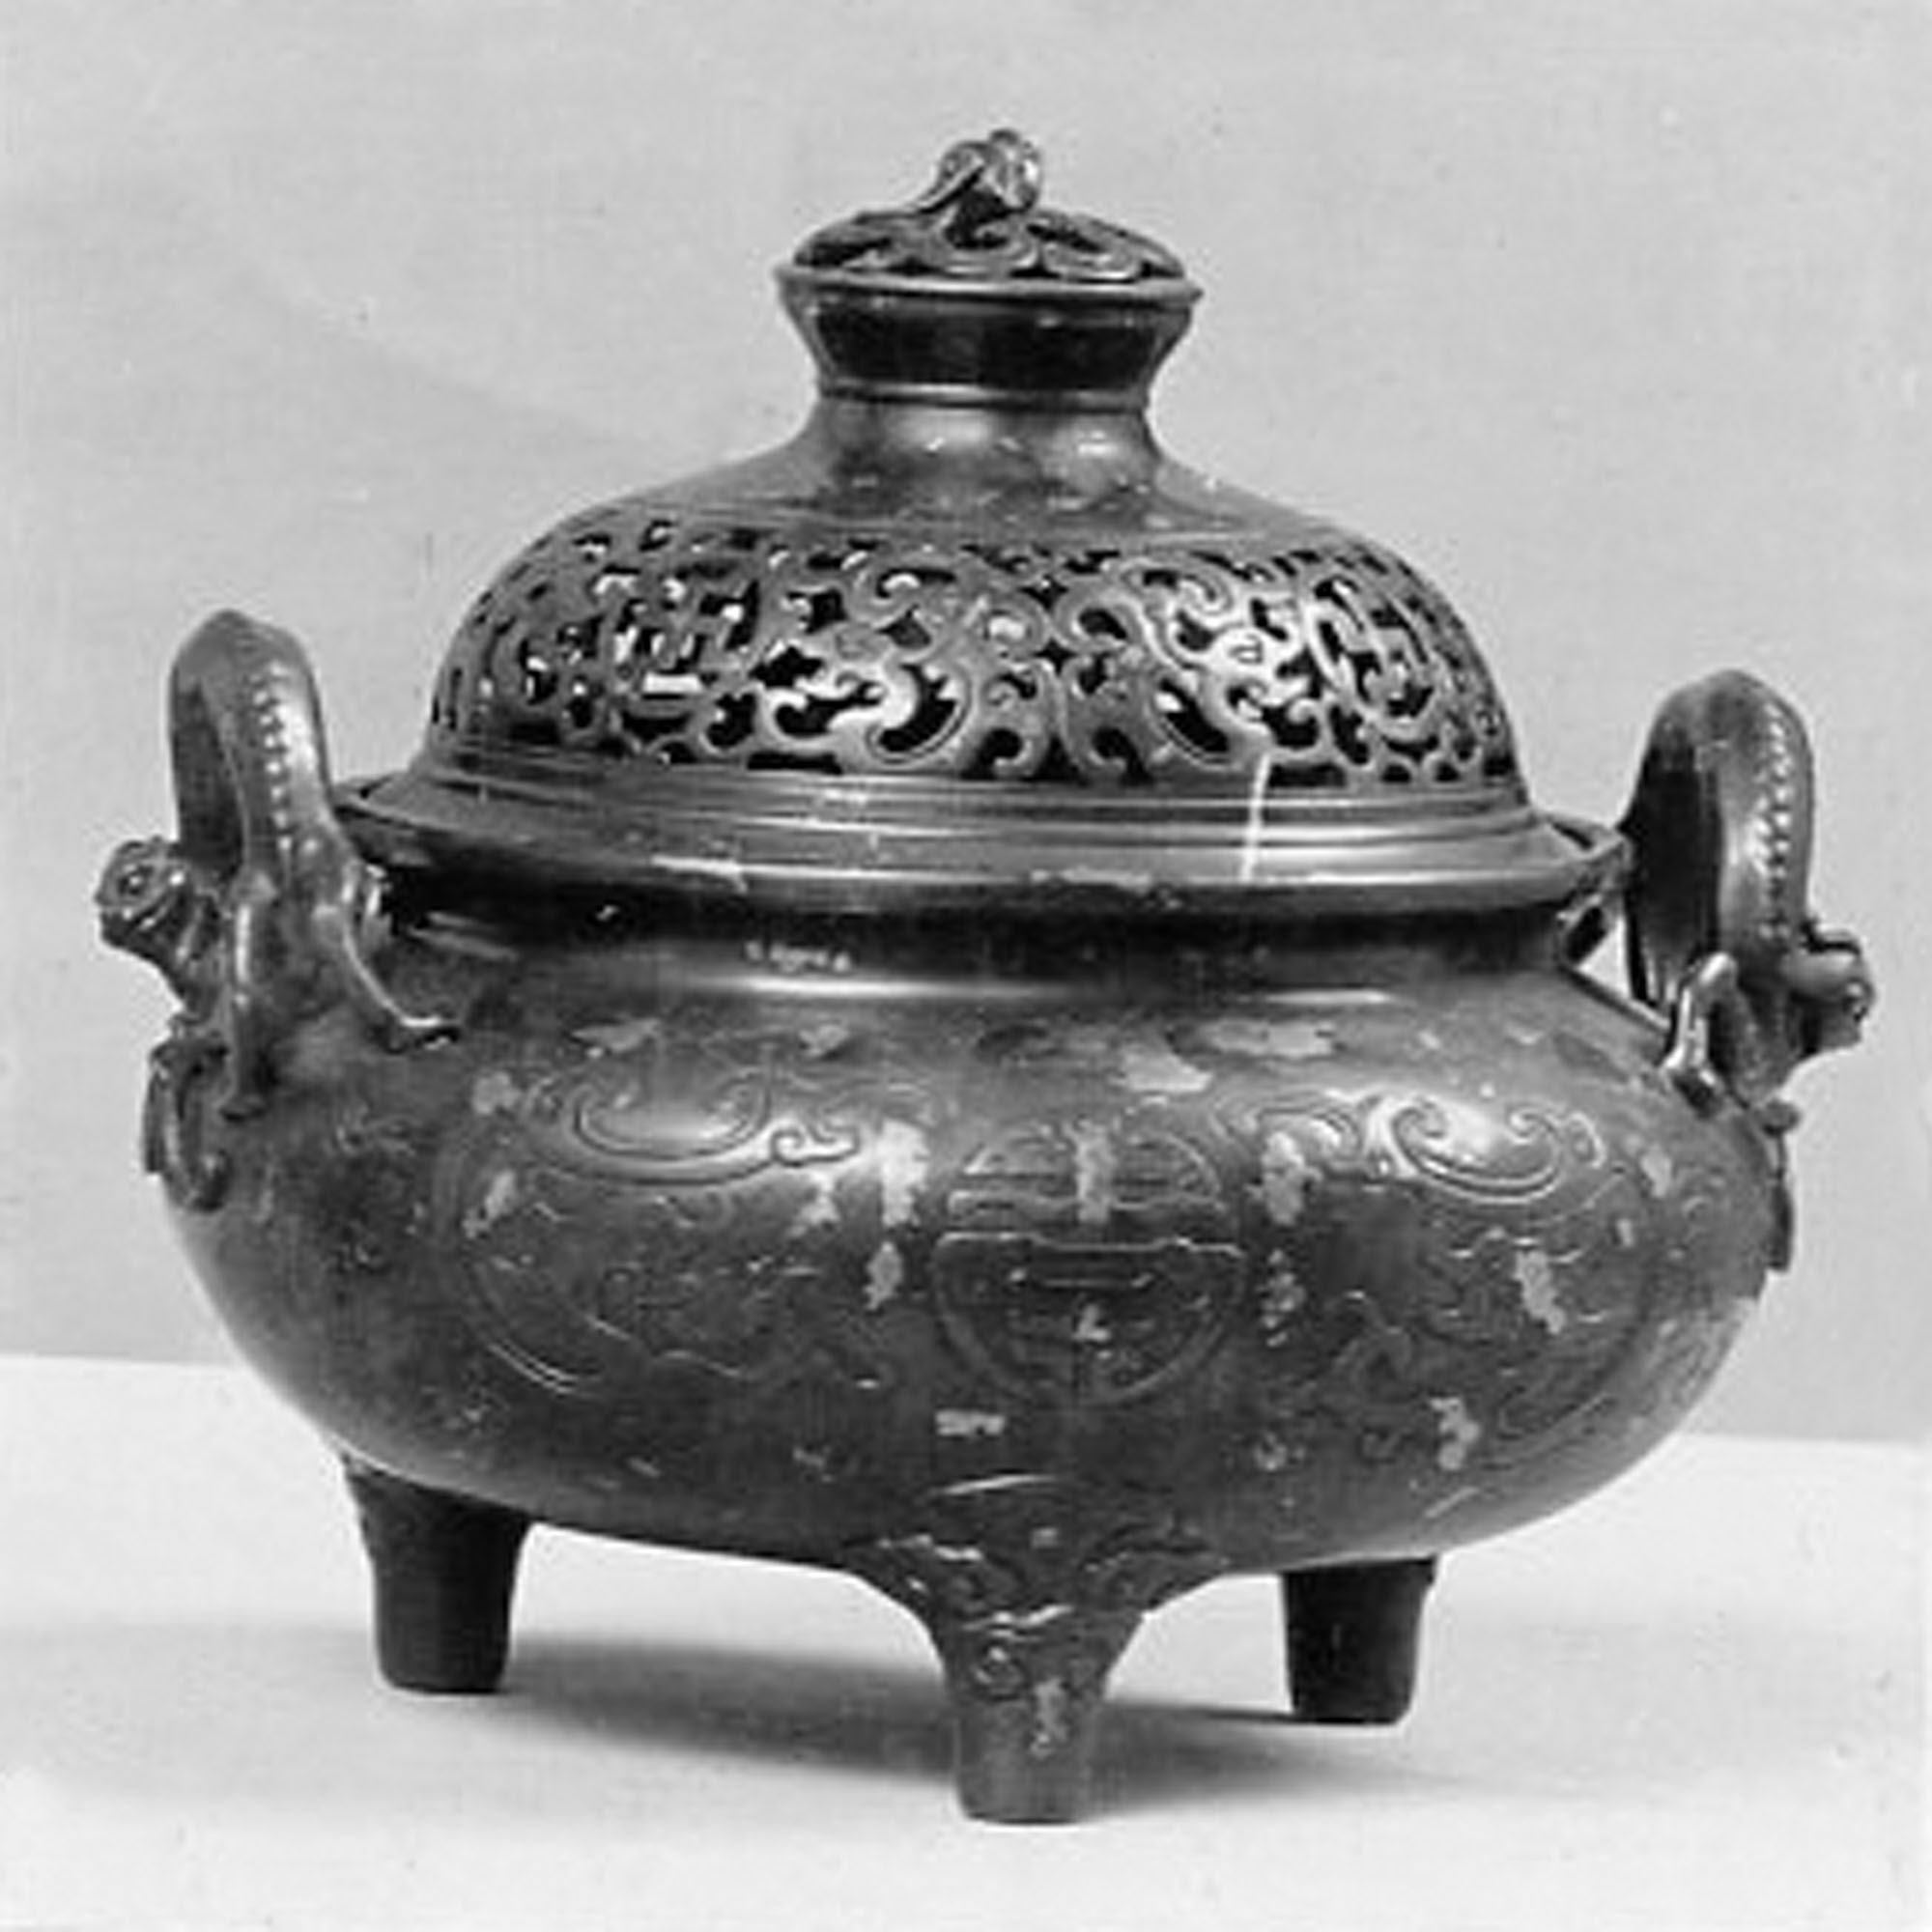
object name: incense burner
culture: chinese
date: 1426-1435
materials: brass, gold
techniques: inlay